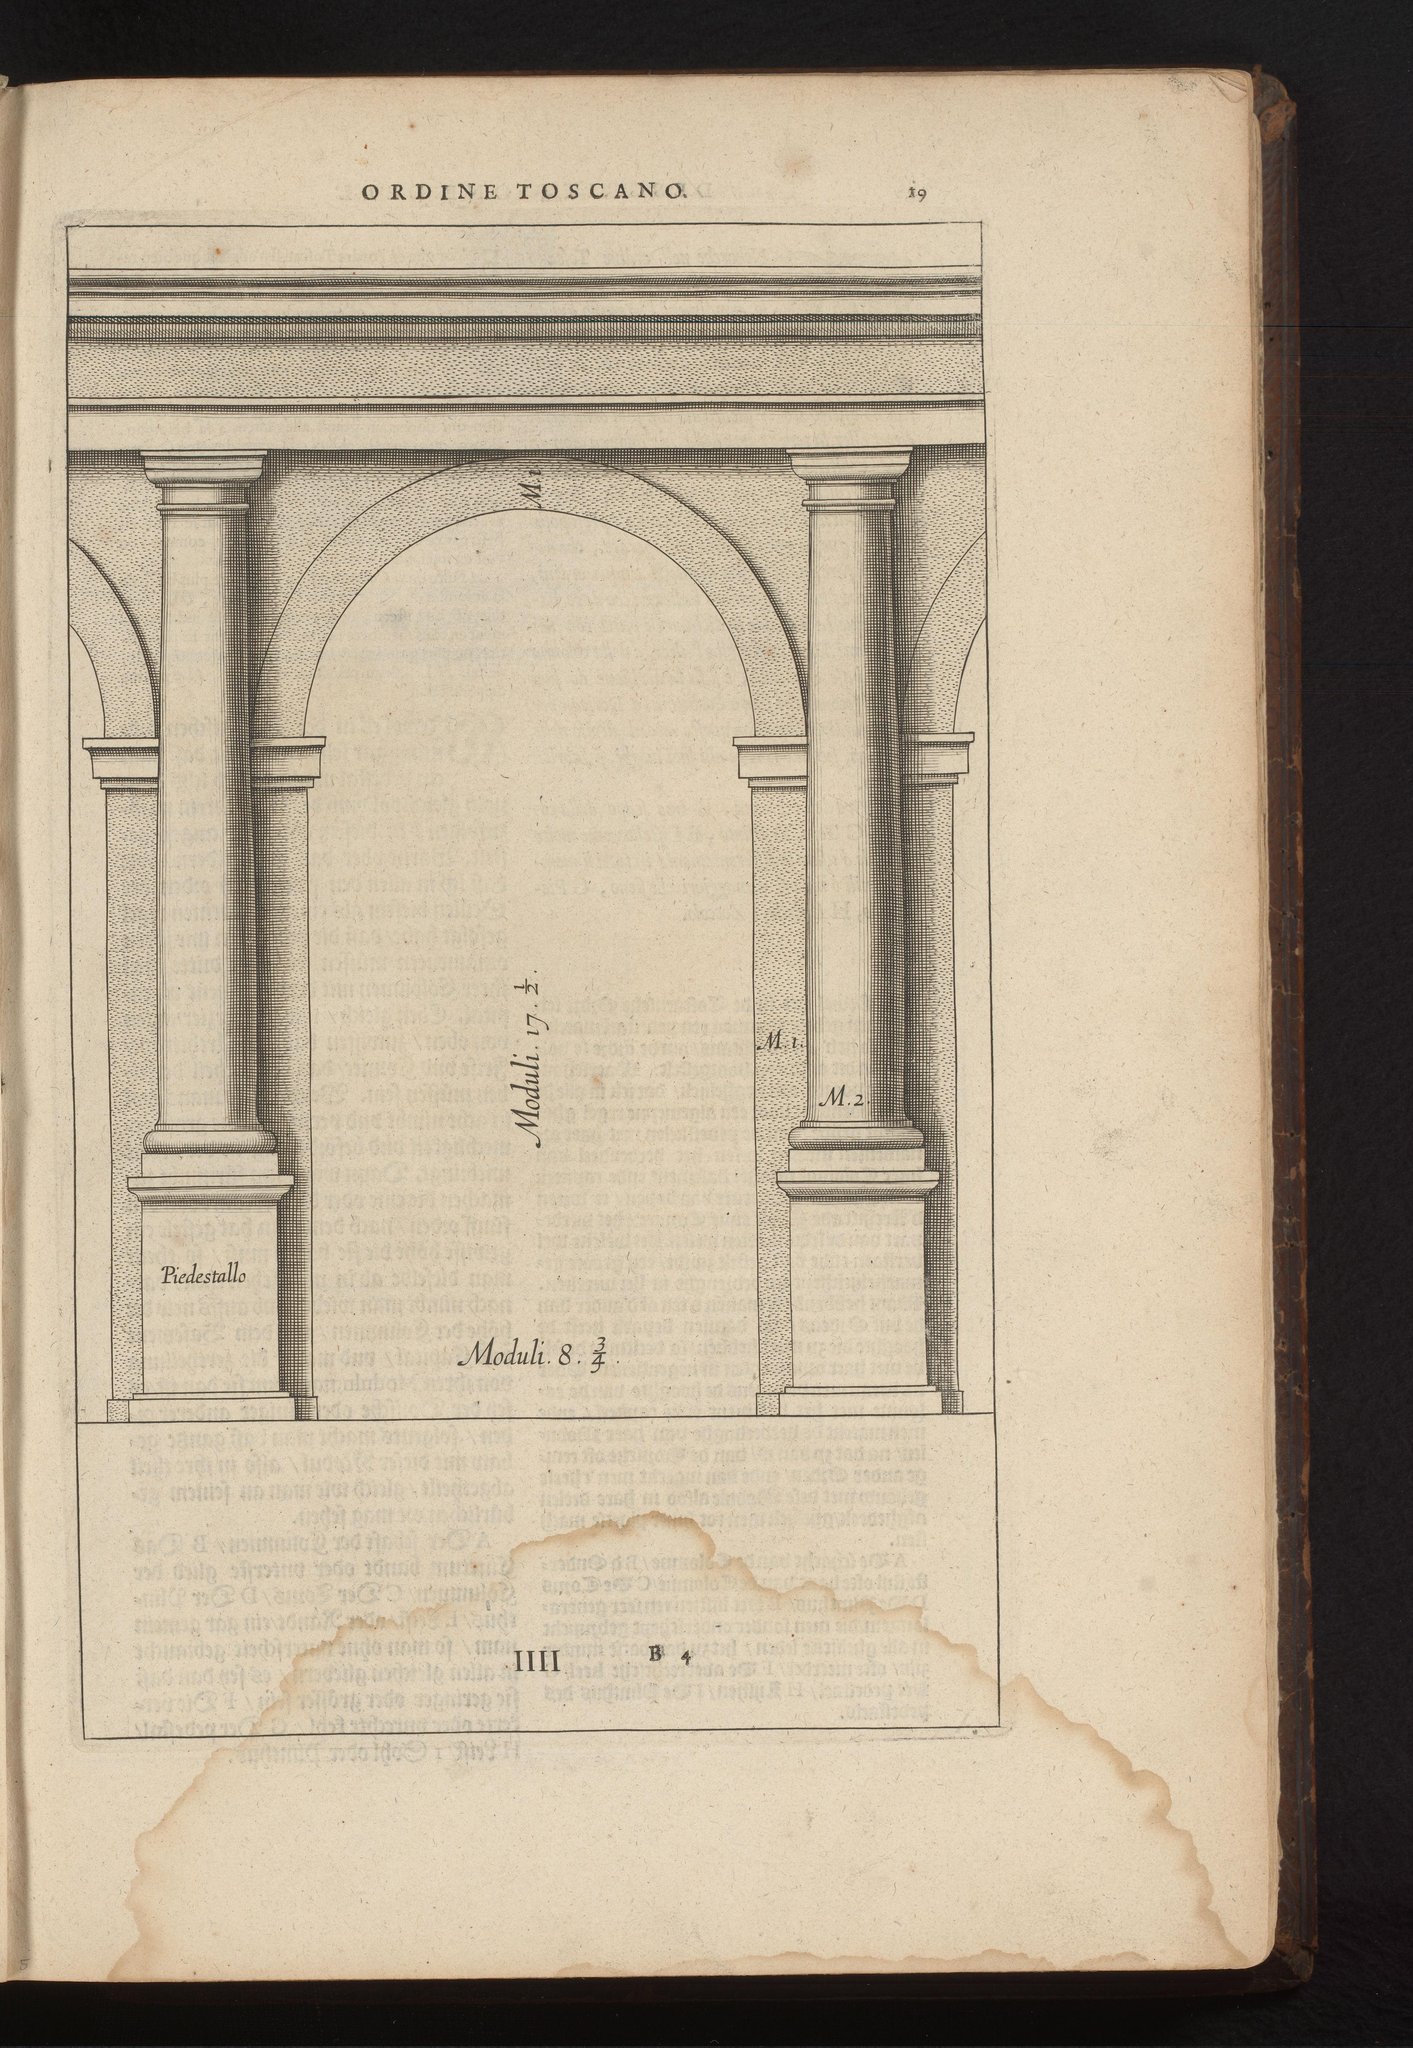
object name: book illustration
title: Toscaanse zuilen met boogconstructie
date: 1640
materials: paper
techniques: engraving, letterpress printing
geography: amsterdam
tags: tuscan order ~ architecture, orders, order-books ~ architecture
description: Prent uit: Vignola, Giacomo Barozzi da. Regola delli cinque ordini d'architettura (...). Amsterdam: Johannes Willemszoon en Cornelis Blaeu, 1640, p. 19.